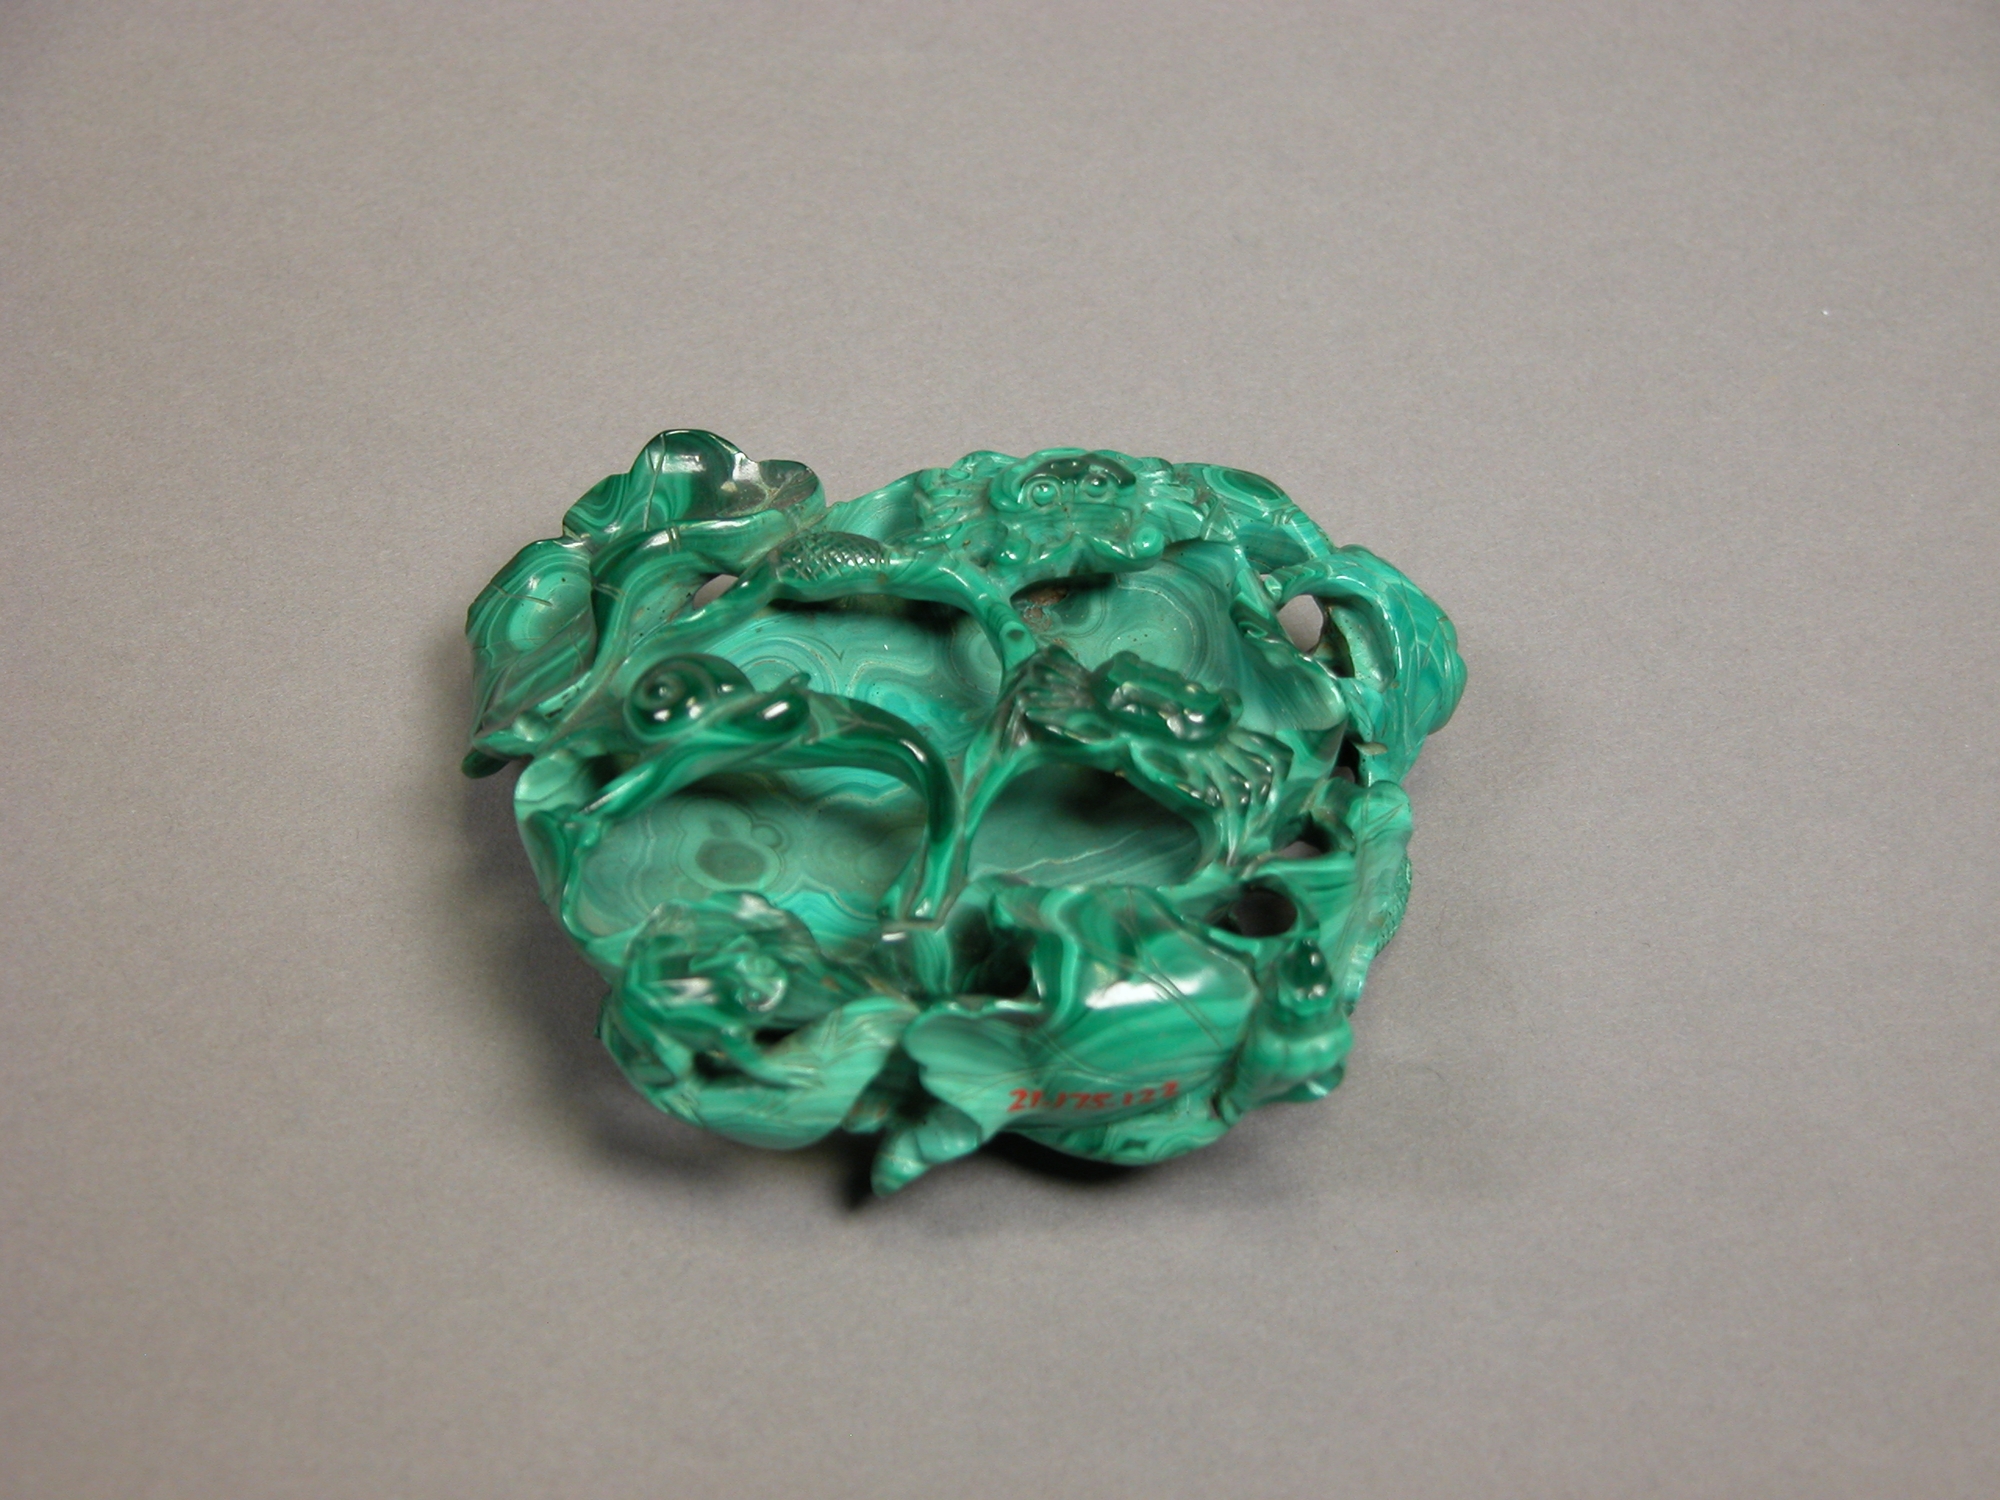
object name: dish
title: Dish with frog and crab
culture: chinese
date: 1644-1911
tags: crabs,frogs